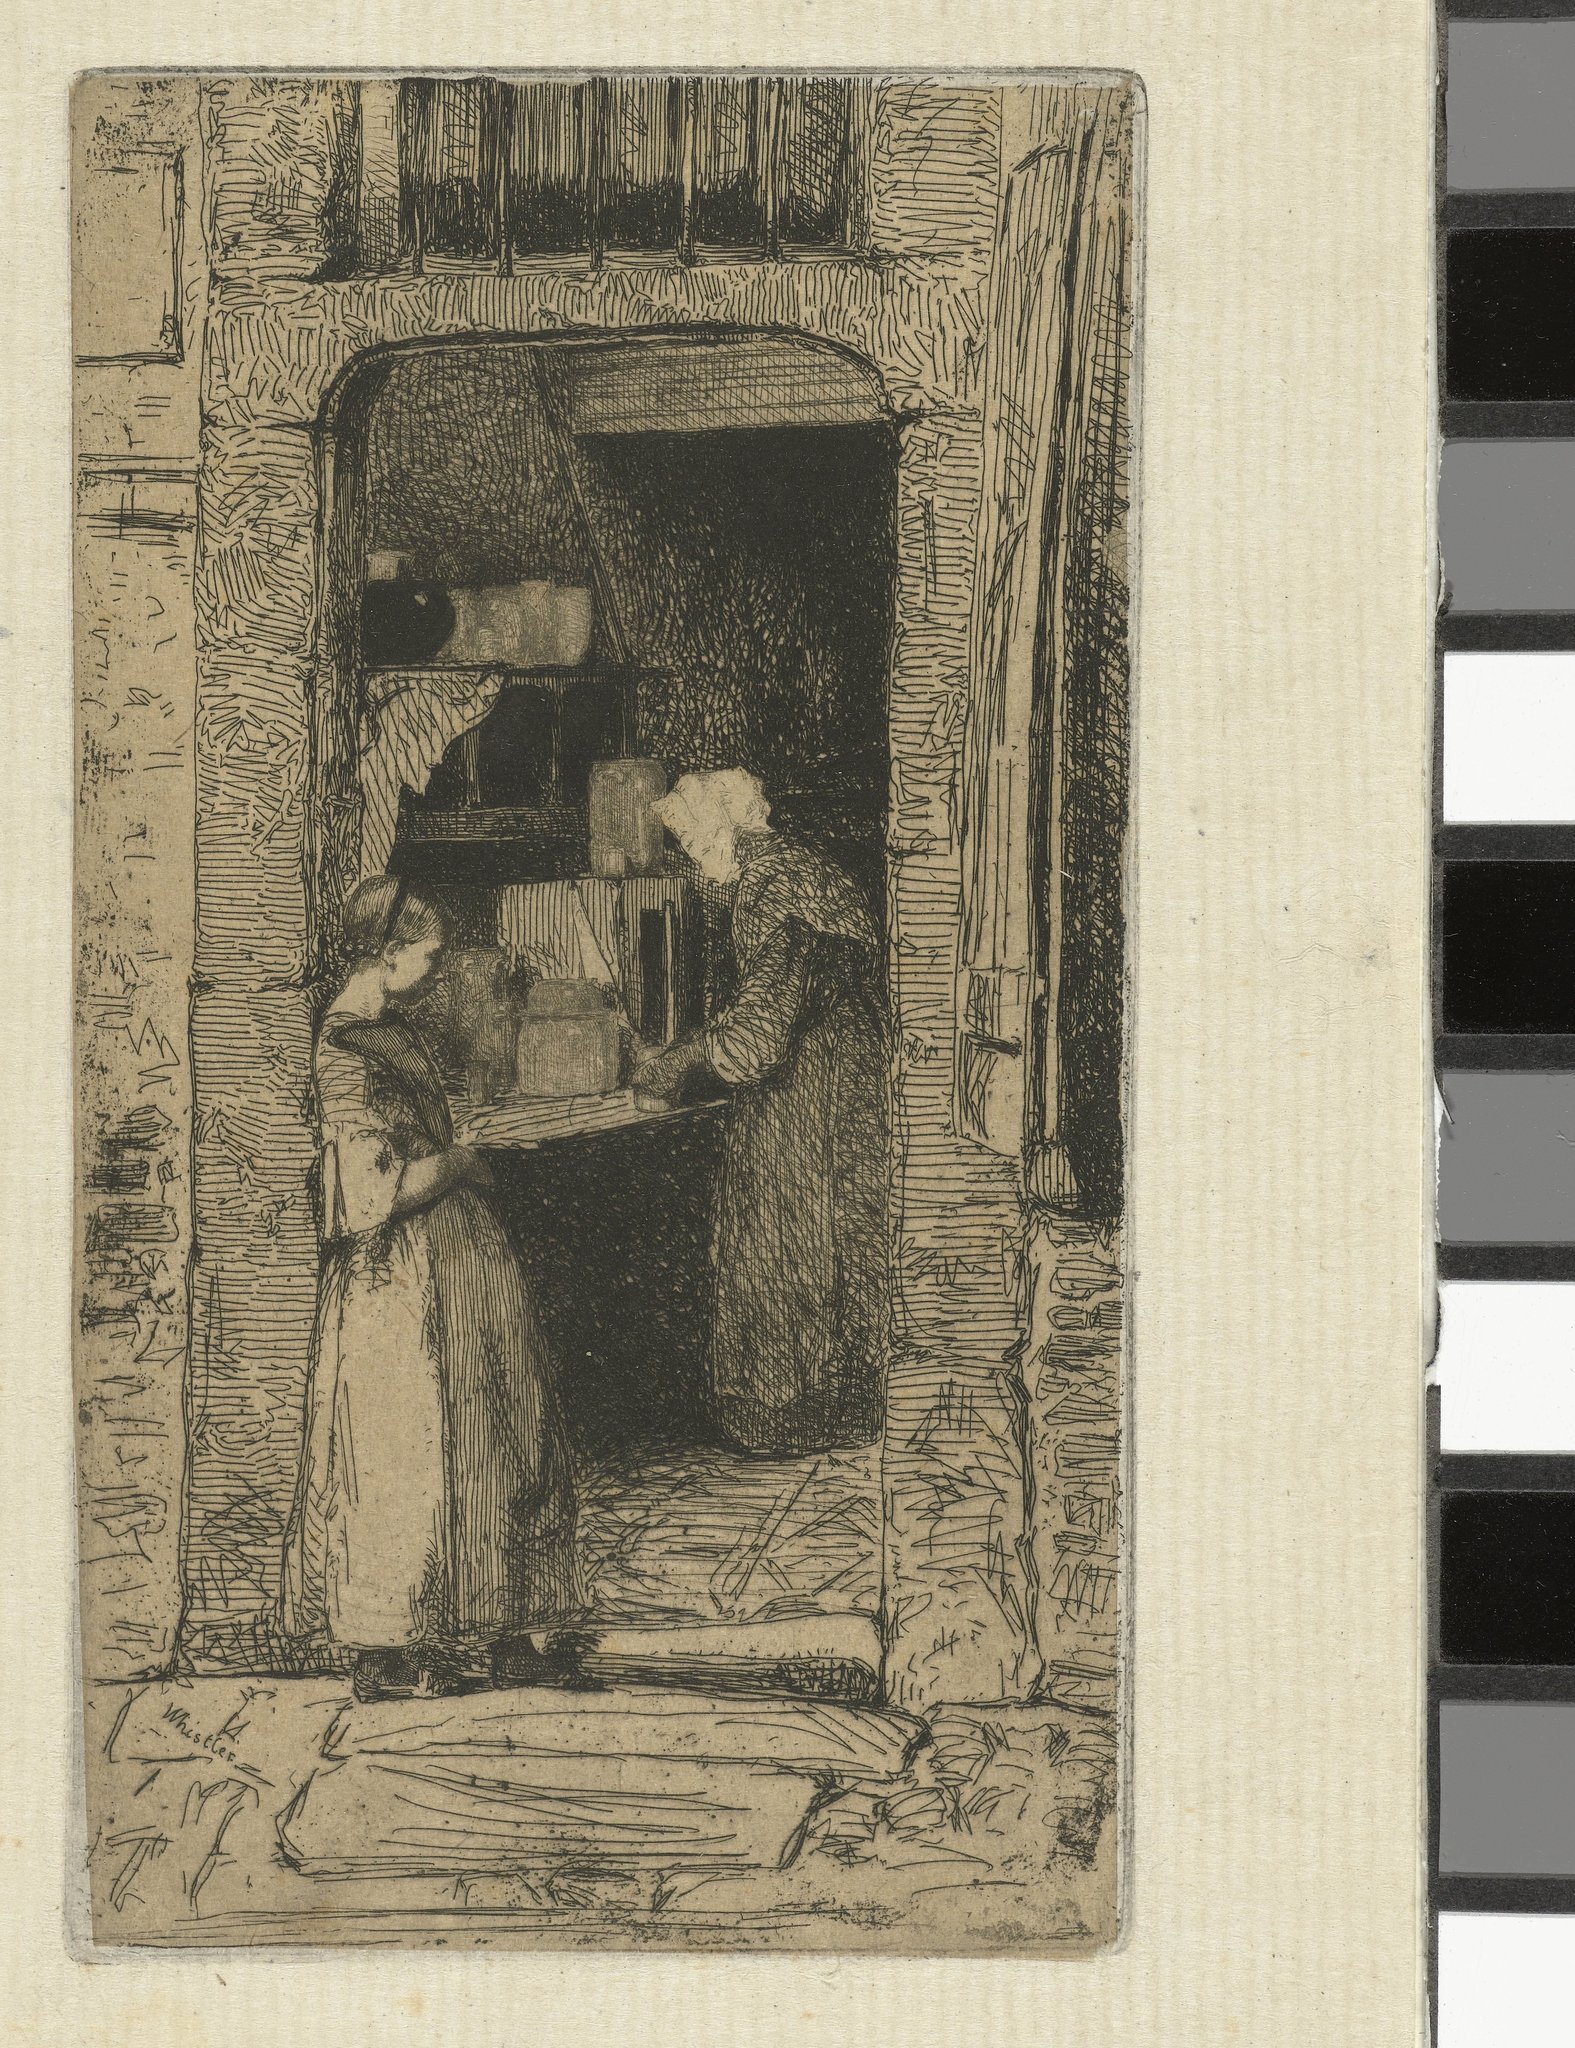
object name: print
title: De mosterdverkoopster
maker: james abbott mcneill whistler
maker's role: painter, print maker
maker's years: 1834-1903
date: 1858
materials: paper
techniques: etching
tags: kitchen, merchant, salesman - bb - women engaged in trade and commerce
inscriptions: collector's mark: Lugt 2166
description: In een deuropening staat een meisje, leunend tegen de deurpost. Daaracht is een vrouw in een keuken aan het werk.